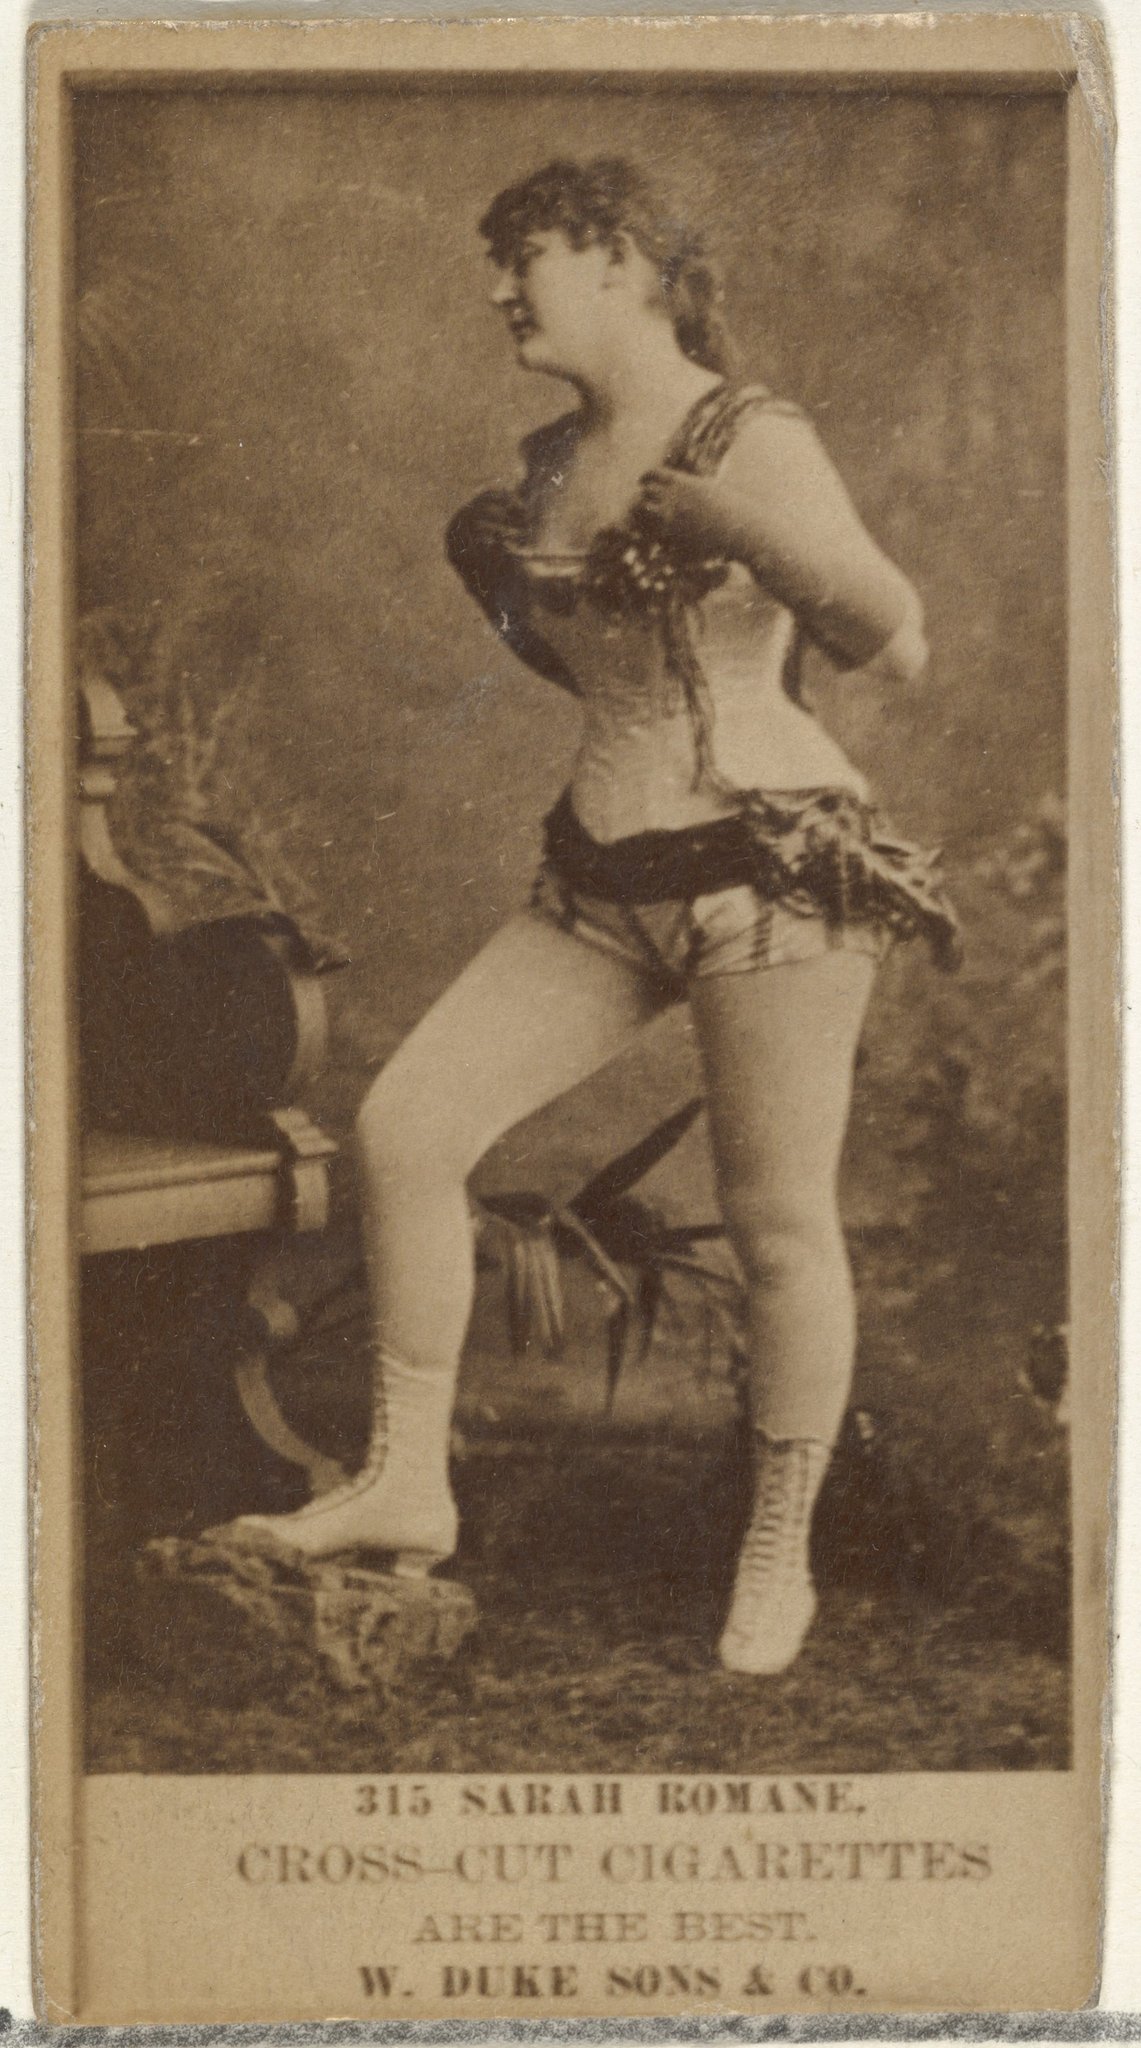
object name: photograph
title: Card Number 315, Sarah Romane, from the Actors and Actresses series (N145-3) issued by Duke Sons & Co. to promote Cross Cut Cigarettes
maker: w. duke, sons & co.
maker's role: publisher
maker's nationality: american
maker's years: 1870-1920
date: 1880-1889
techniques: albumen silver print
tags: women,actresses